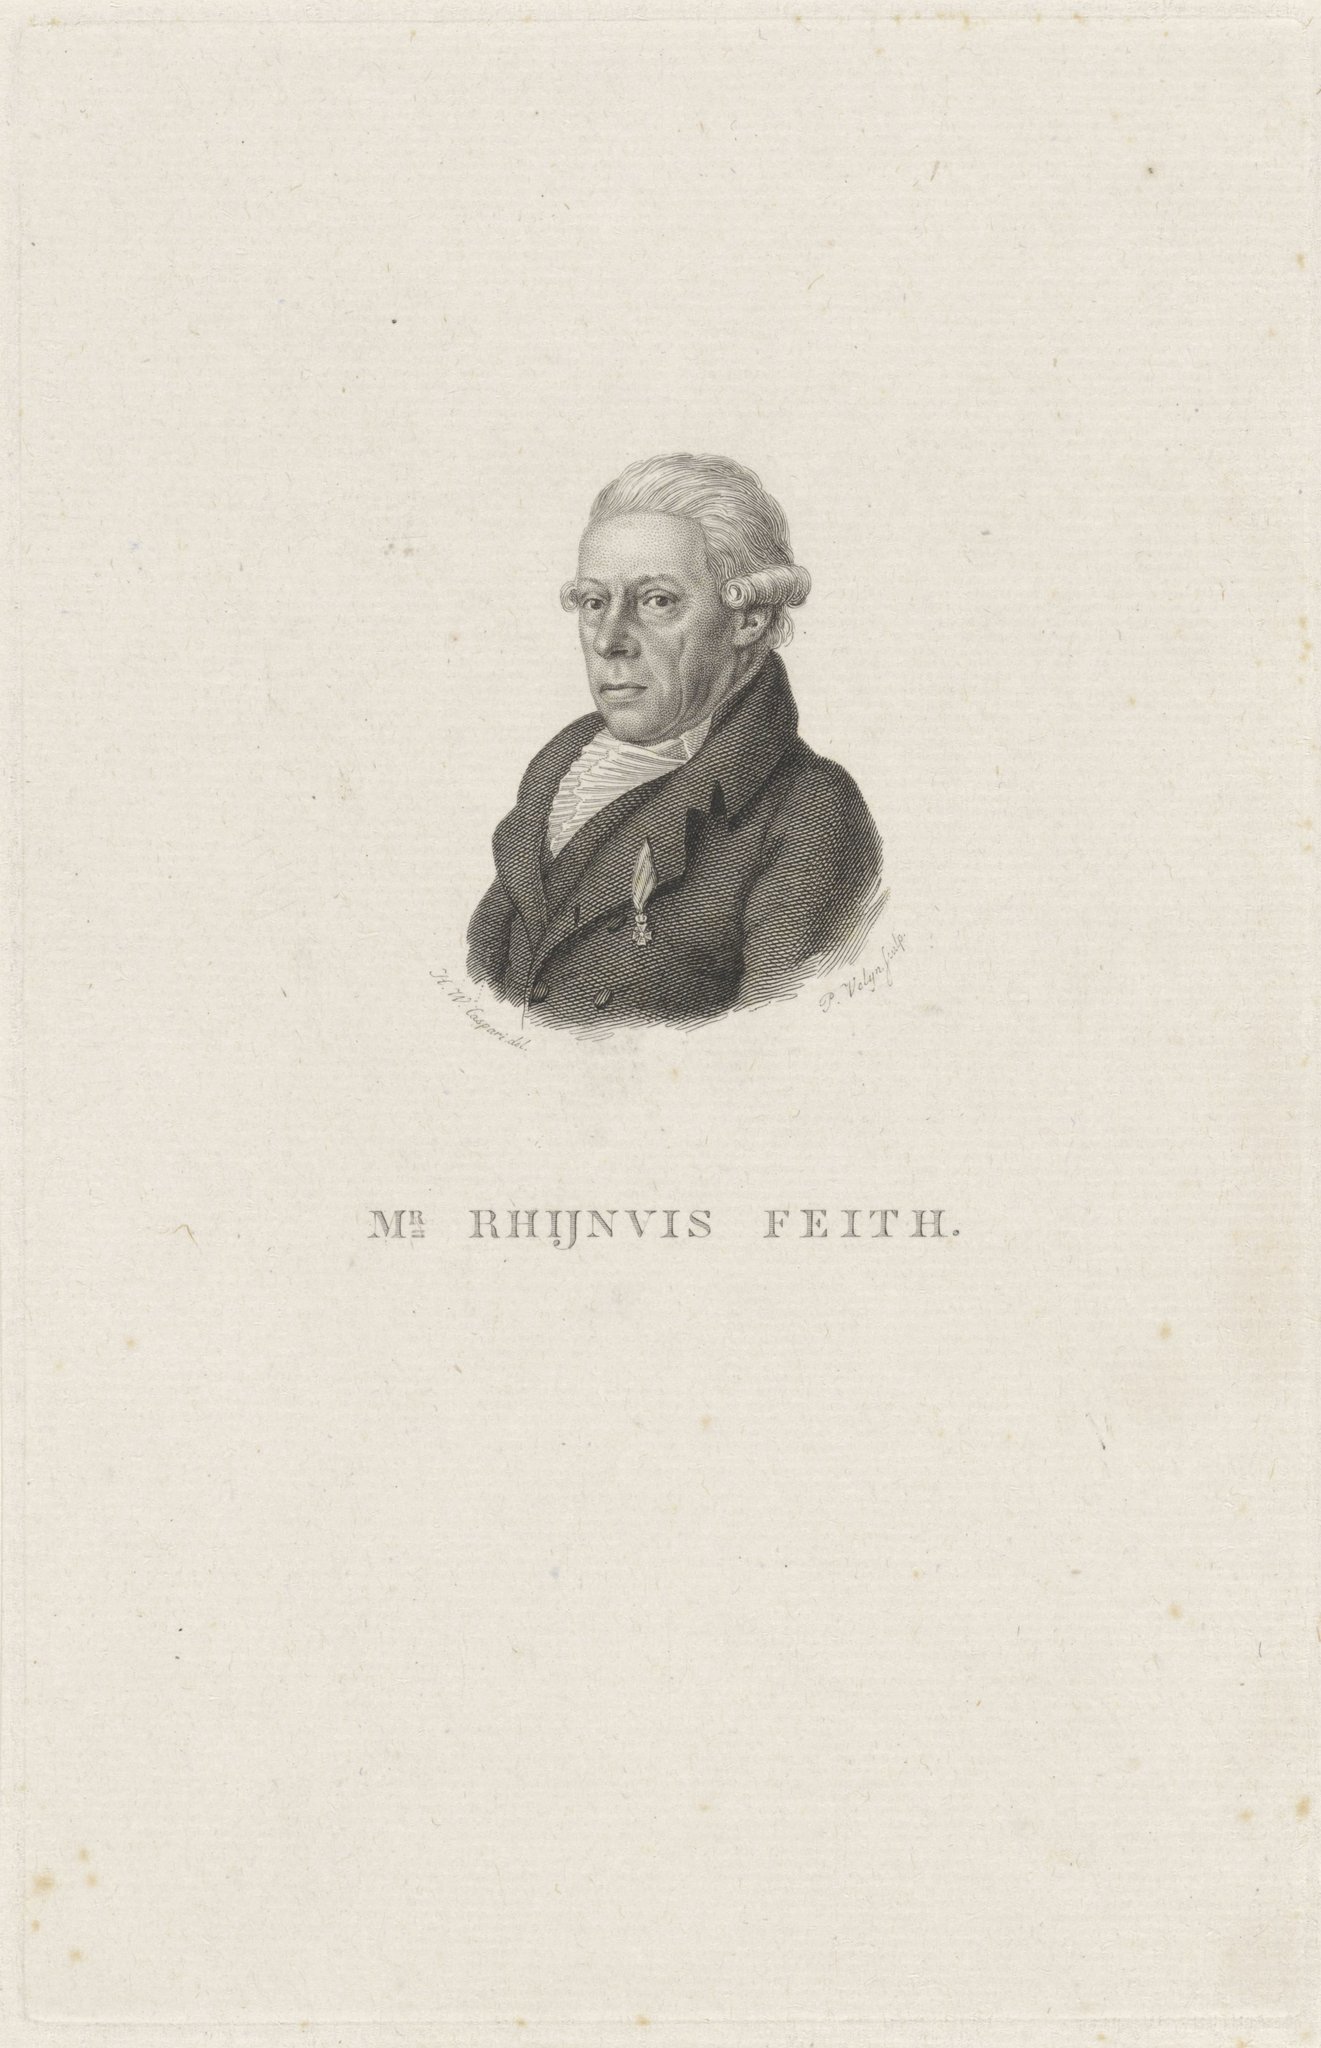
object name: print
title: Portret van Rijnvis Feith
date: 1797-1836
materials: paper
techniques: engraving, etching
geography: netherlands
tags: rhijnvis feith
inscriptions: collector's mark: Lugt 2228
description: Portret van de dichter en advocaat Rhijnvis Feith.